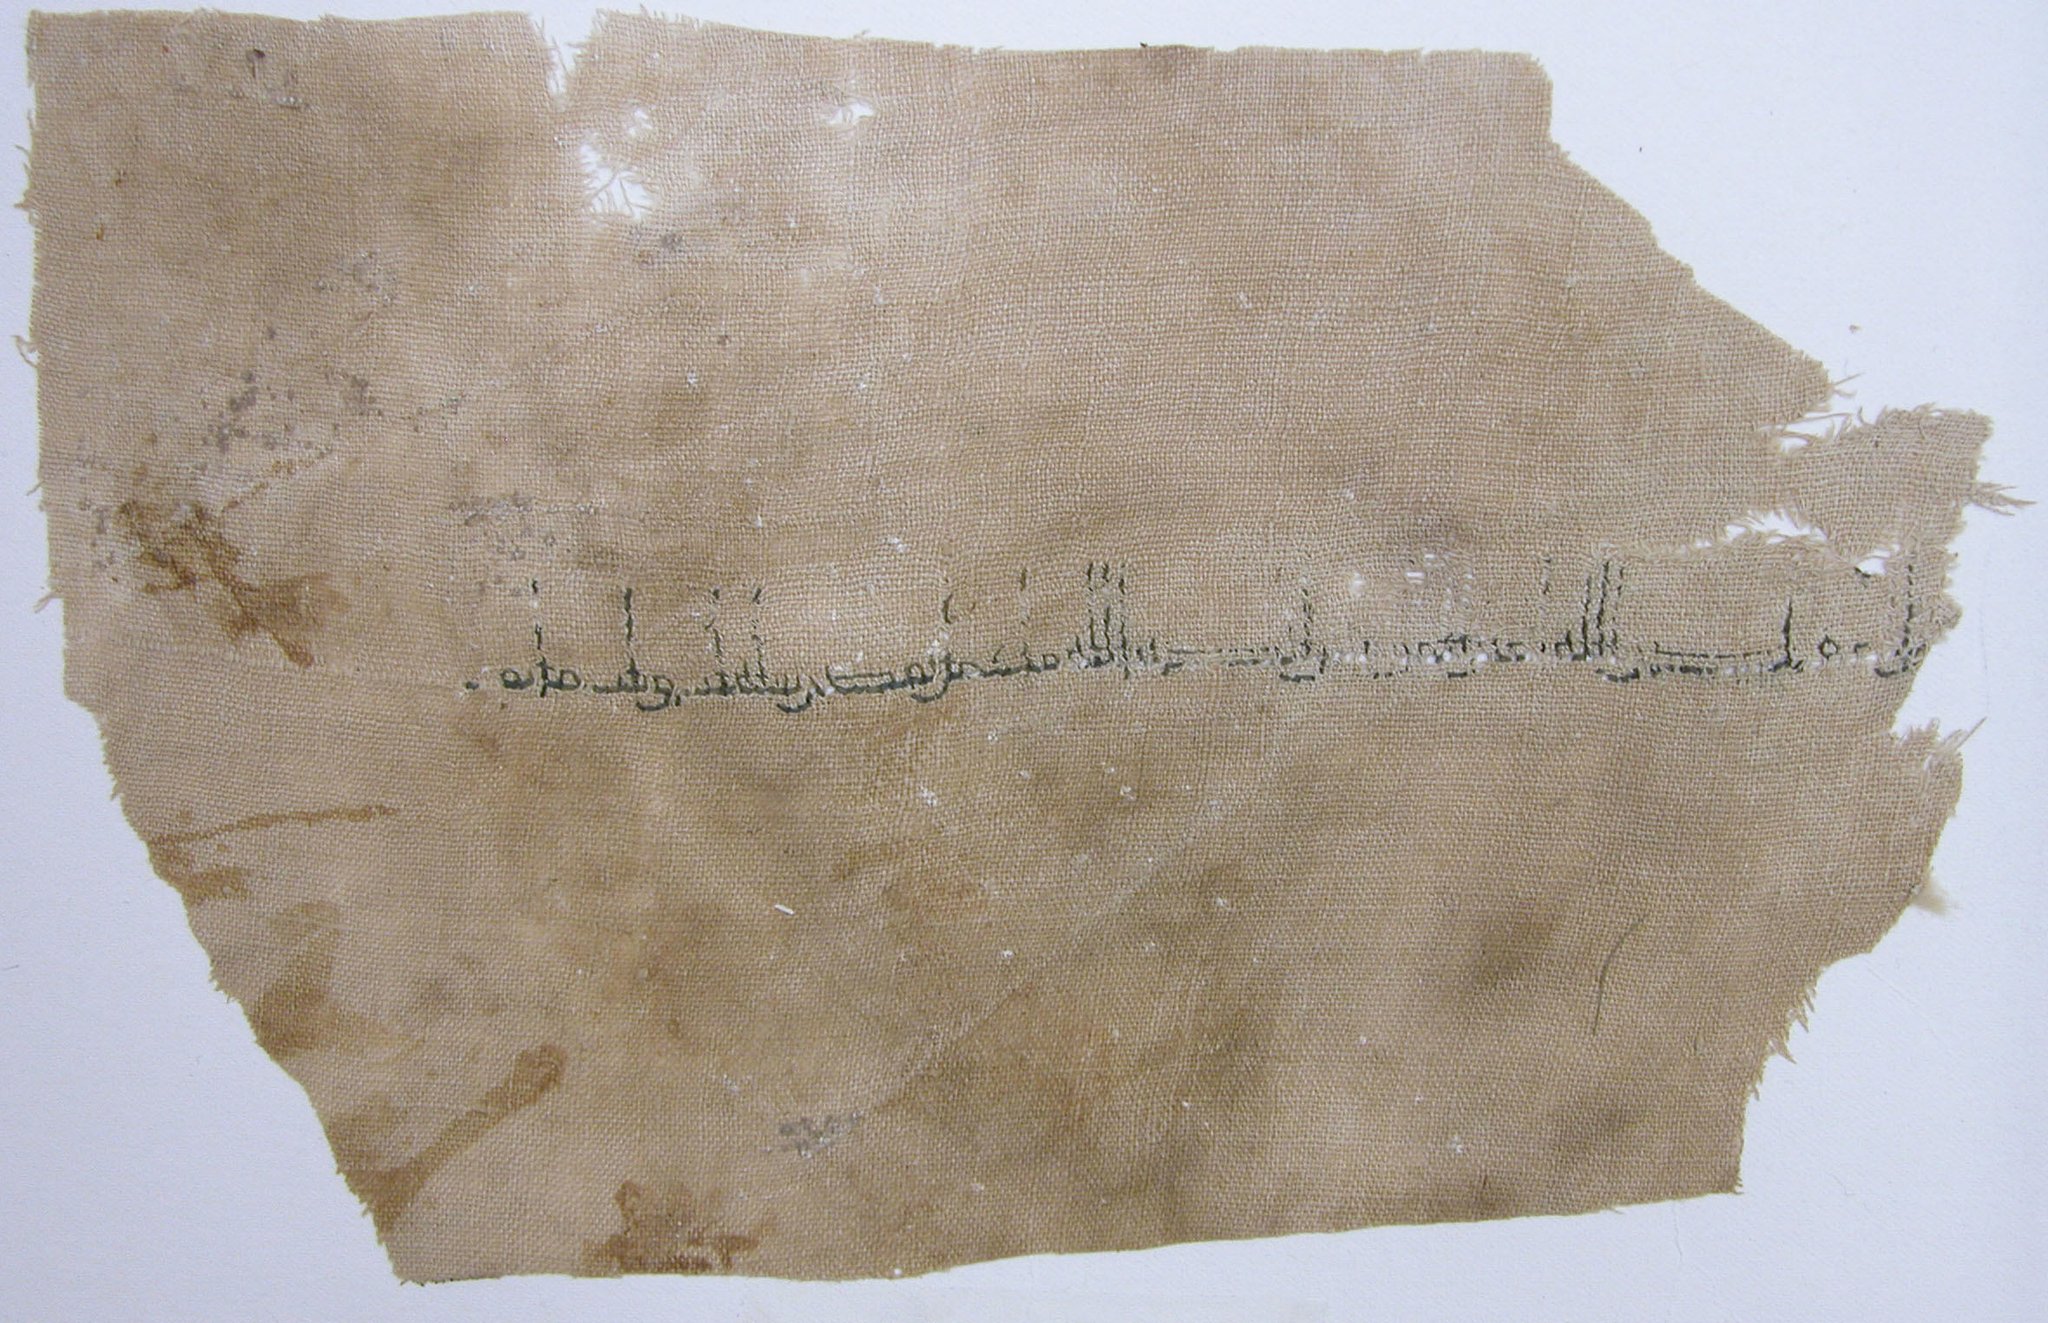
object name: textile fragment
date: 908-932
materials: linen, silk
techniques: embroidery, weave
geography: egypt